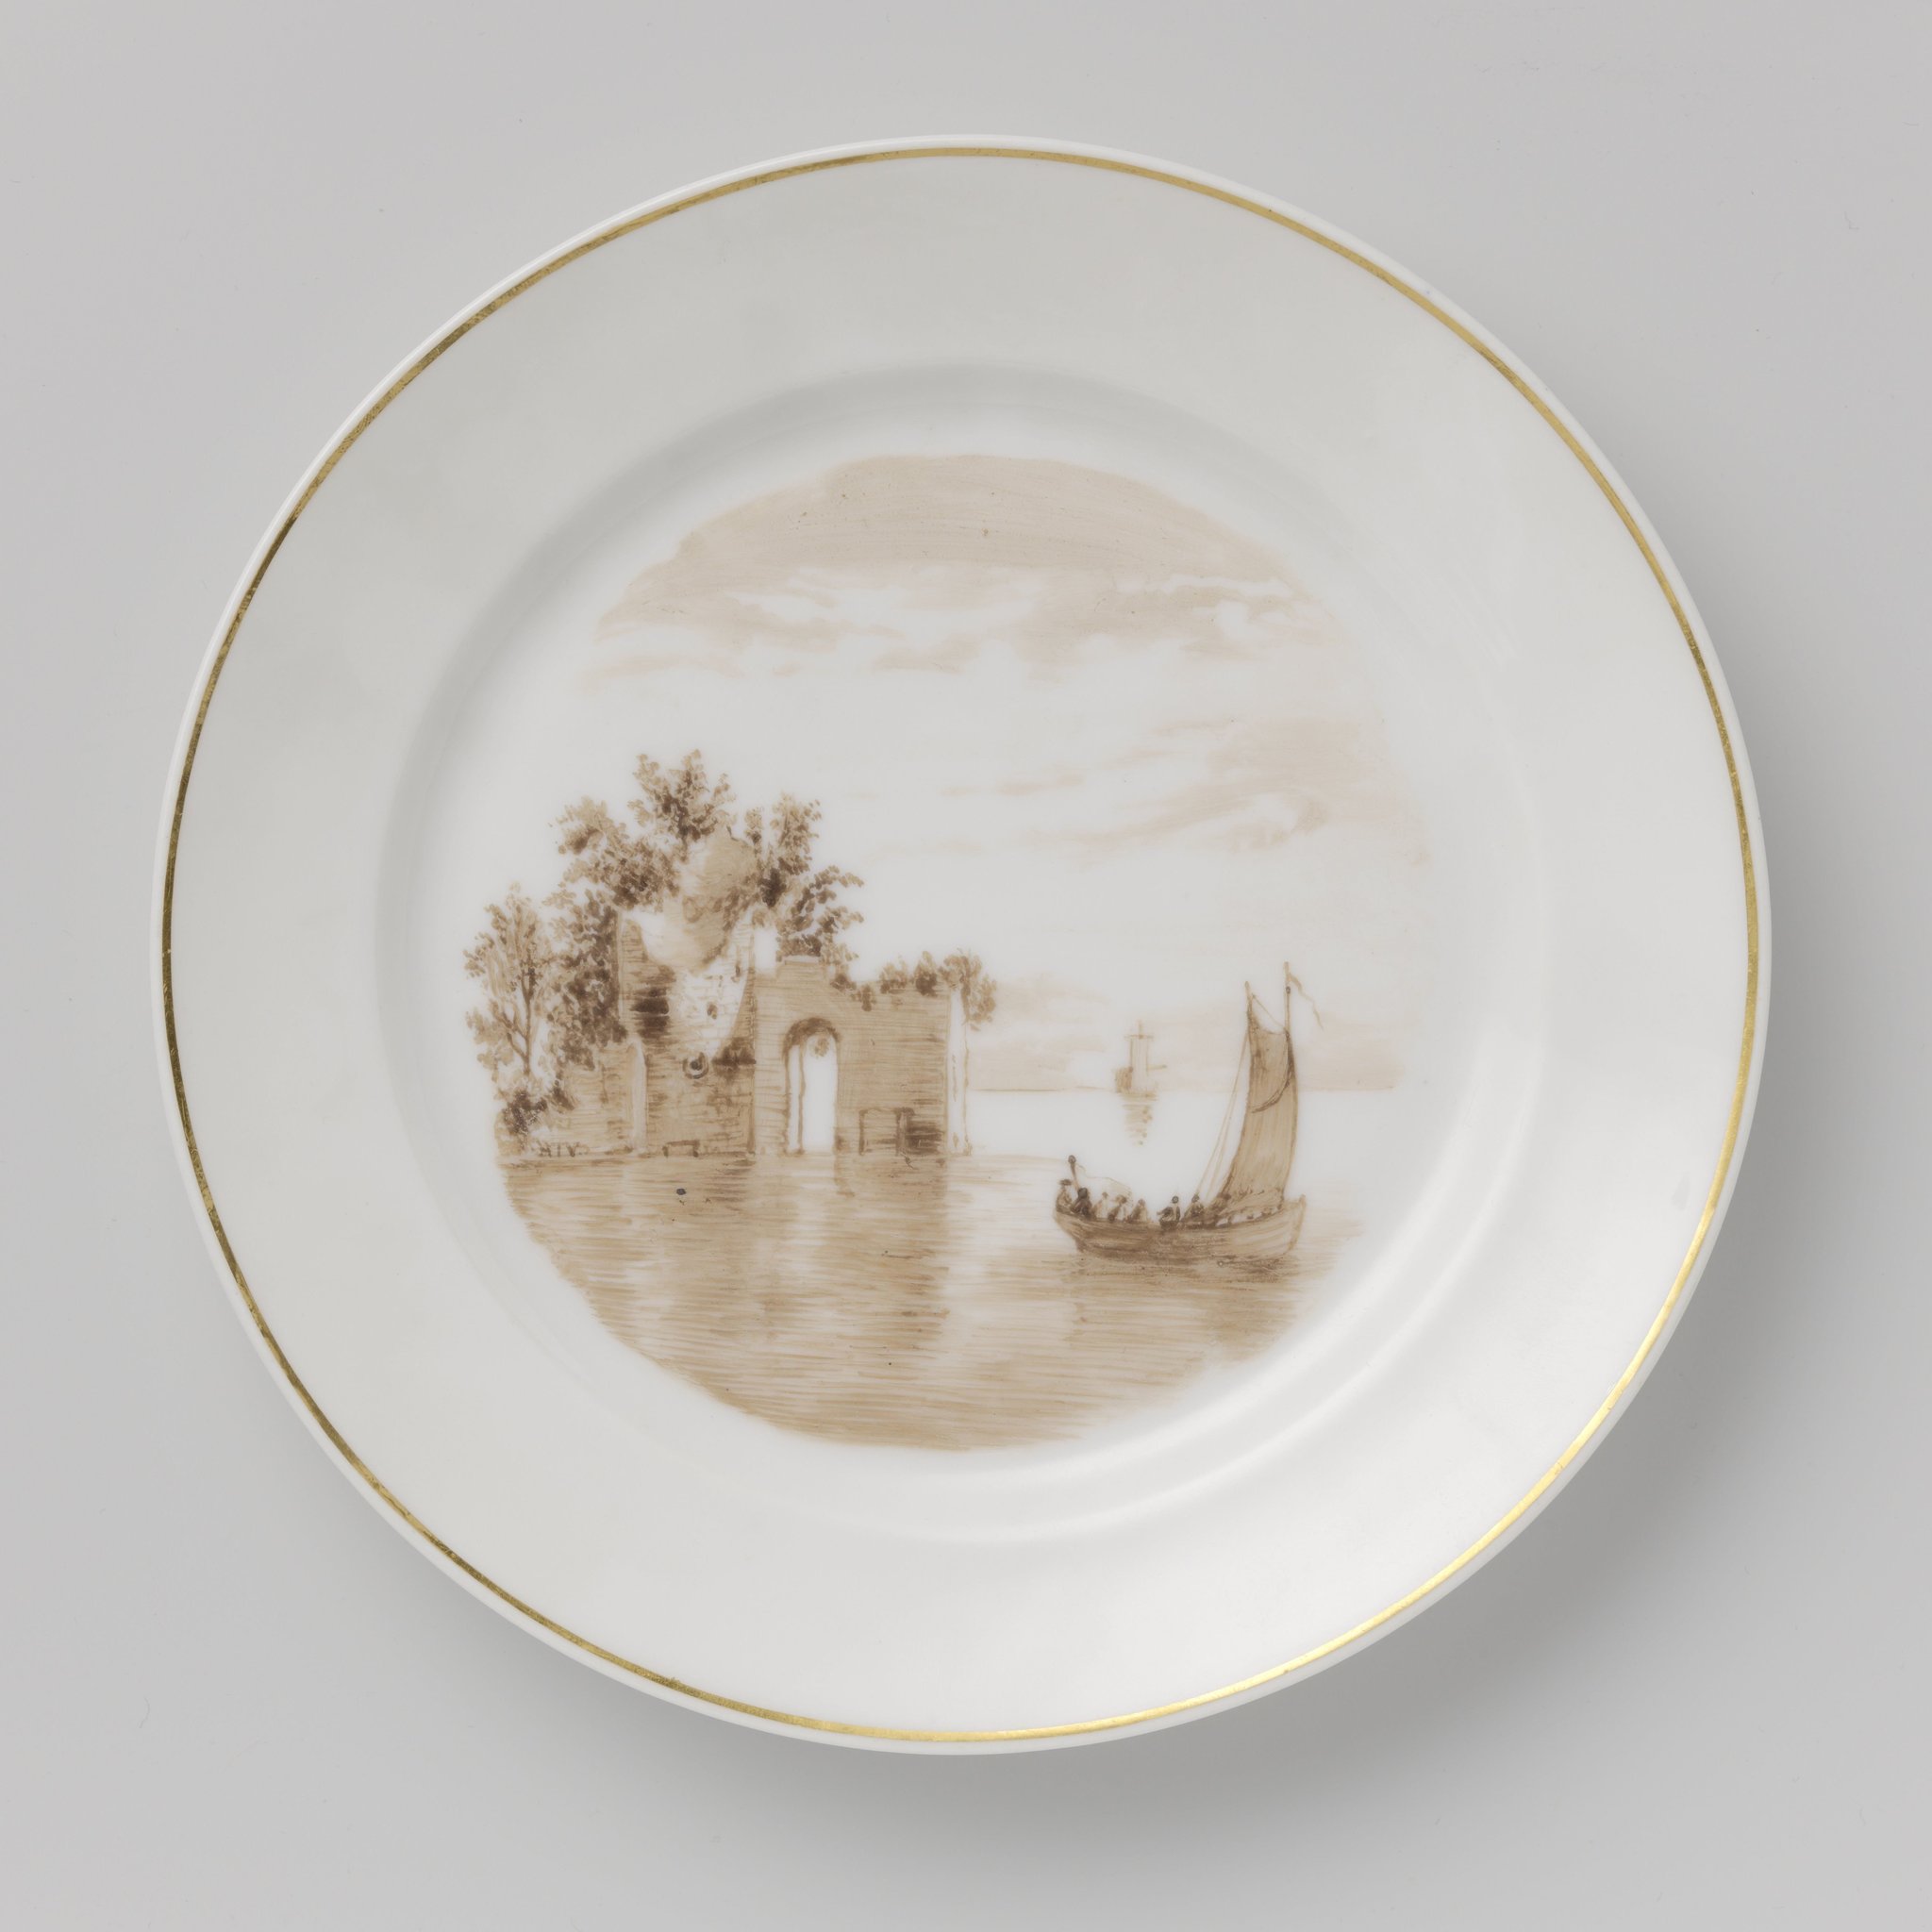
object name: plate dish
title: Plate with a landscape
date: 1850-1860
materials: glaze, gold, paint, porcelain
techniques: firing, forming, gilding, turning, vitrification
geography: europe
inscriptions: mark: ‘12’, signature: ‘A.T.V.’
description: Bord van porselein, beschilderd op het glazuur in sepia en goud. Op het plat een landschap met een zeilboot varend langs een kasteelruïne in zee. Op de achtergrond een tweede boot. Gouden rand. Een proen op de onderzijde. Gesigneerd in de voorstelling met A.T.V en gemerkt op de onderzijde met 12.